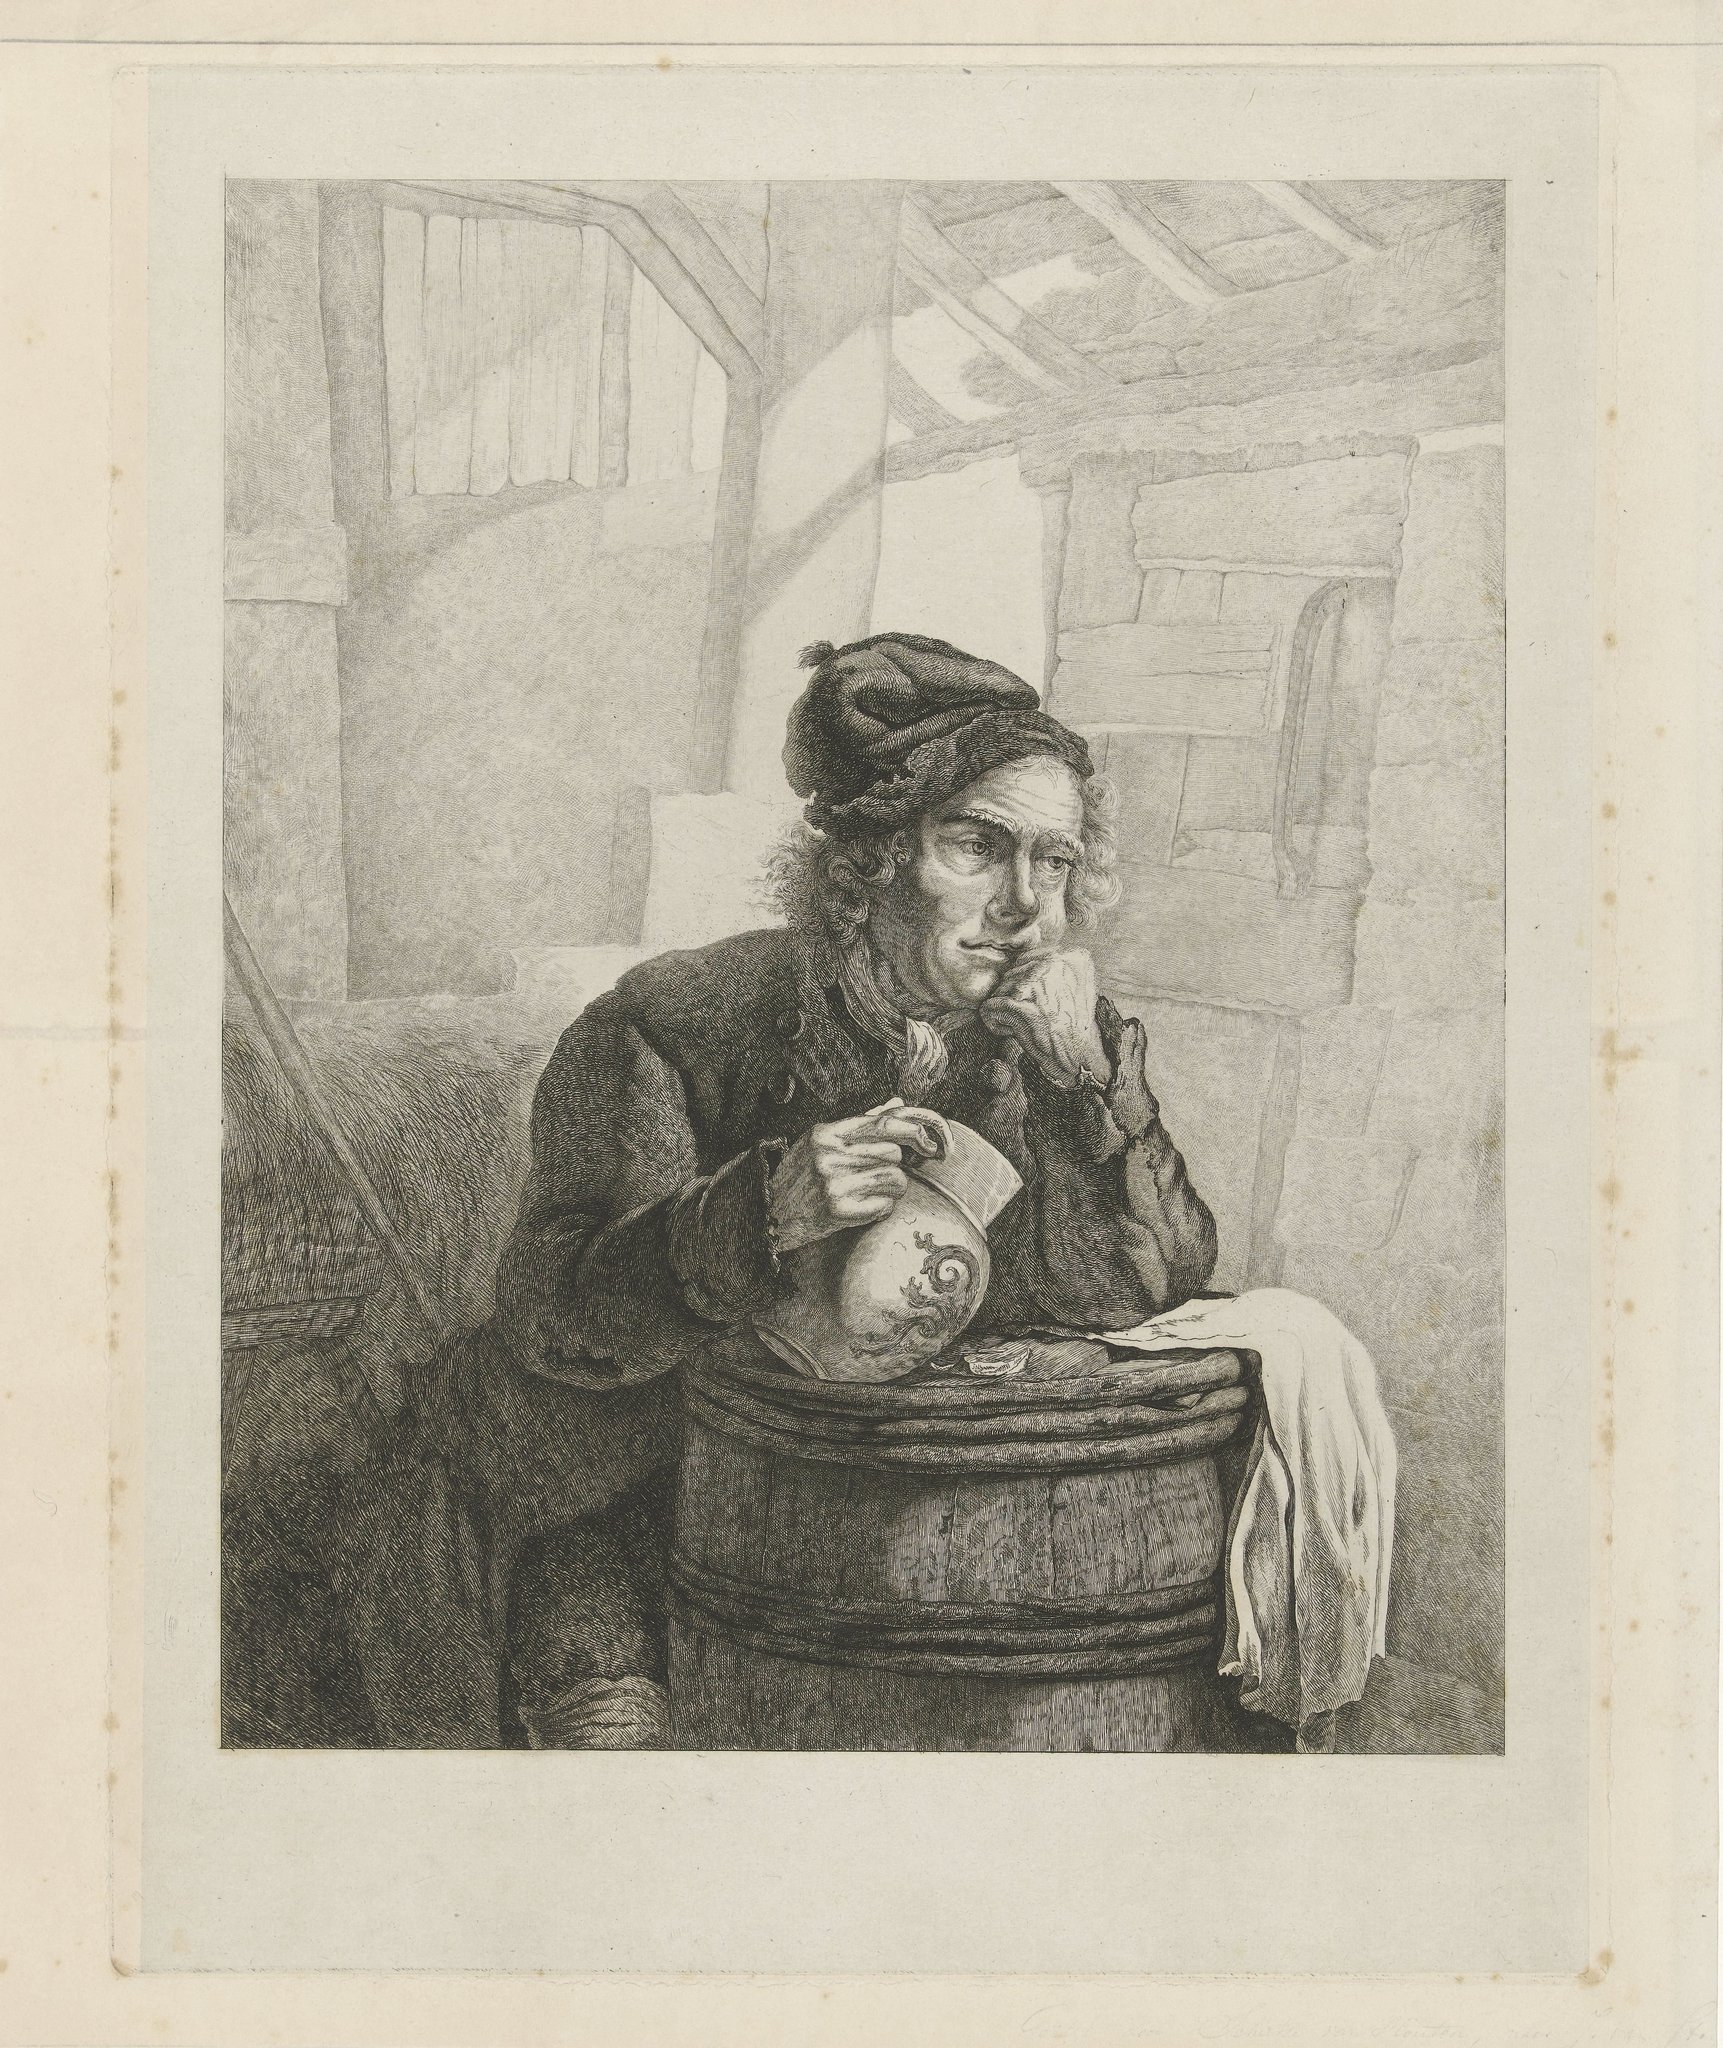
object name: print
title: Man met kruik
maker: christiaan godfried schutze van houten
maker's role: print maker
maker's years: 1807-1869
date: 1821-1869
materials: paper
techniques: engraving, etching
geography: rotterdam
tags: adult man, container of ceramics: jar, jug, pot, vase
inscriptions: collector's mark: Lugt 2228, collector's mark: Lugt 1485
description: Een zittende man leunt op een vat en staart voor zich uit in een binnenruimte. In zijn rechterhand een kruik.